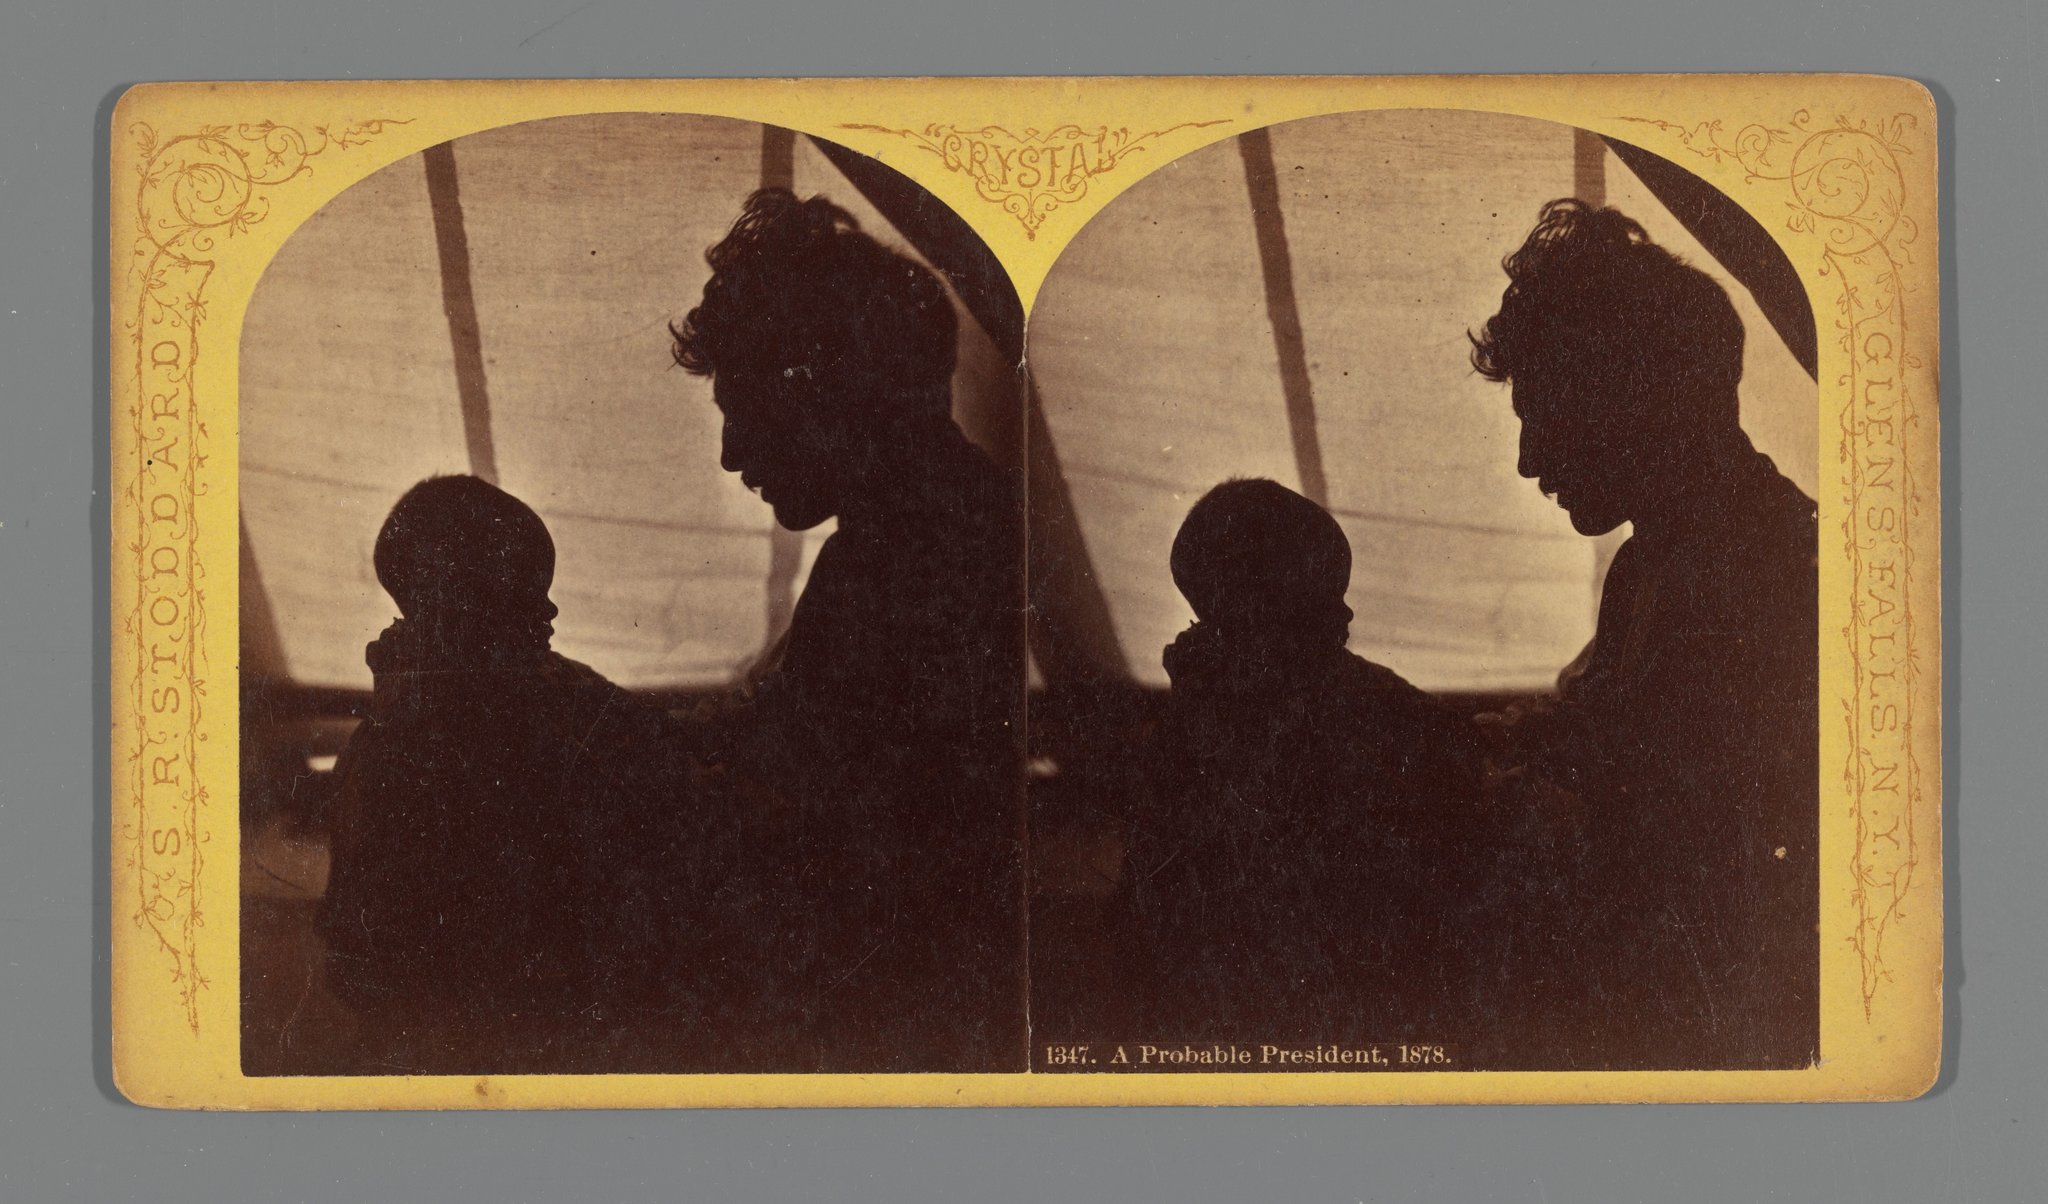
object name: photograph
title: A Probable President (Zelfportret met kind in silhouette)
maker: seneca ray stoddard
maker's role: fotograaf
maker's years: 1843-1917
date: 1878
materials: cardboard, photographic support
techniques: albumen print